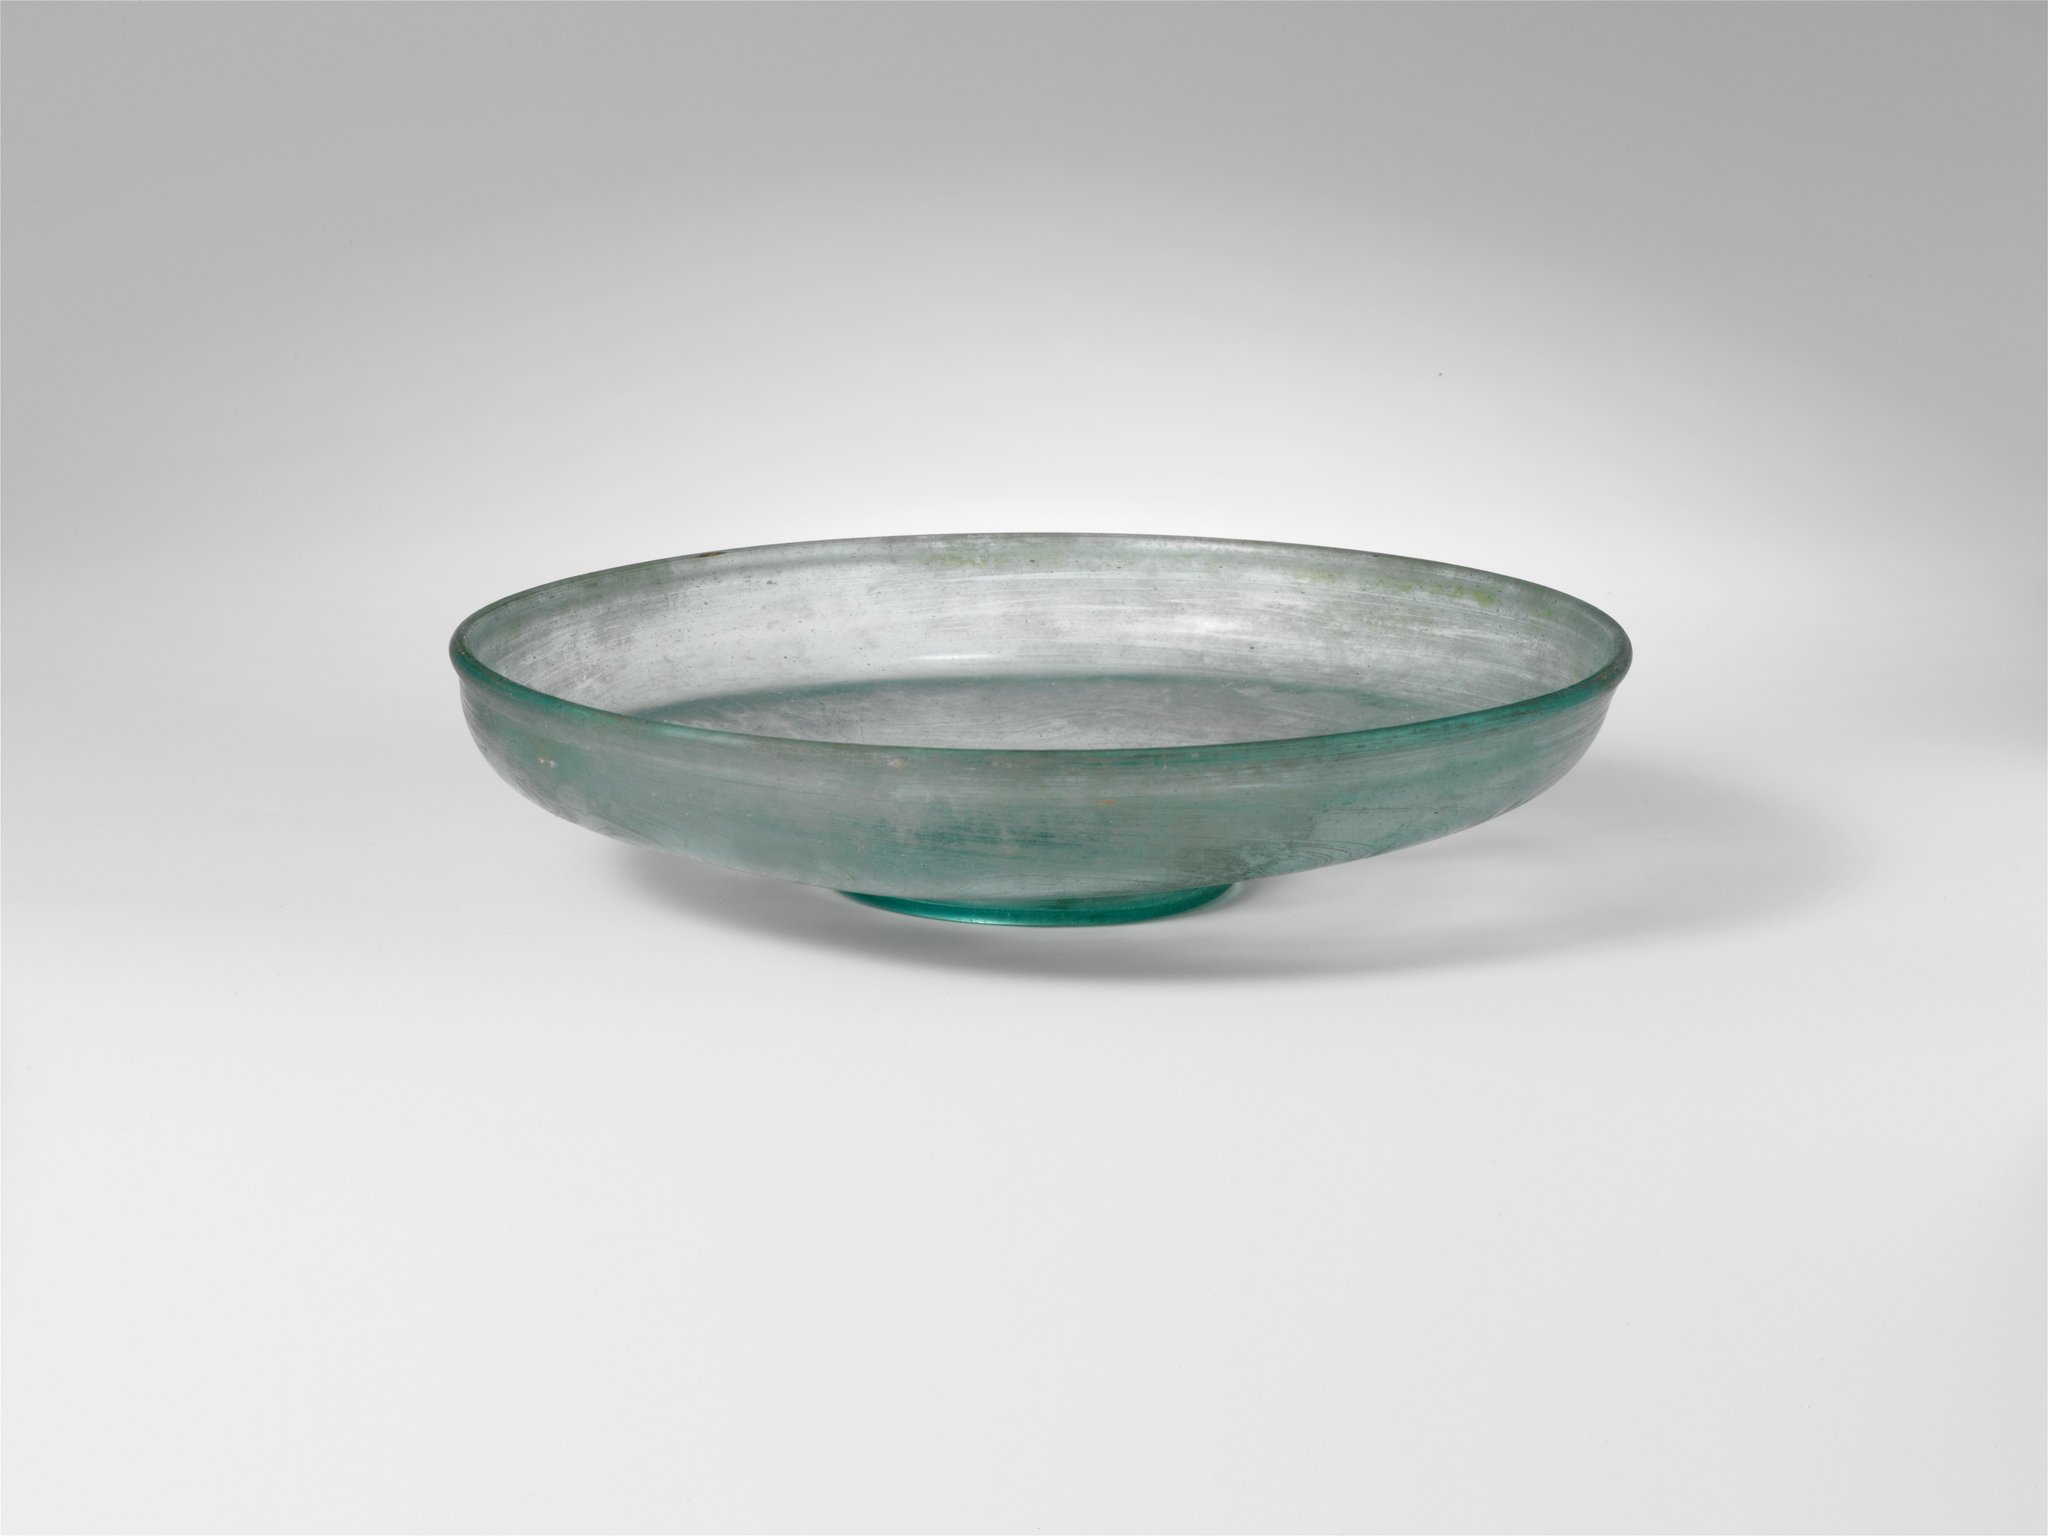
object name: dish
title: Glass dish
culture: roman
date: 301-400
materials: glass